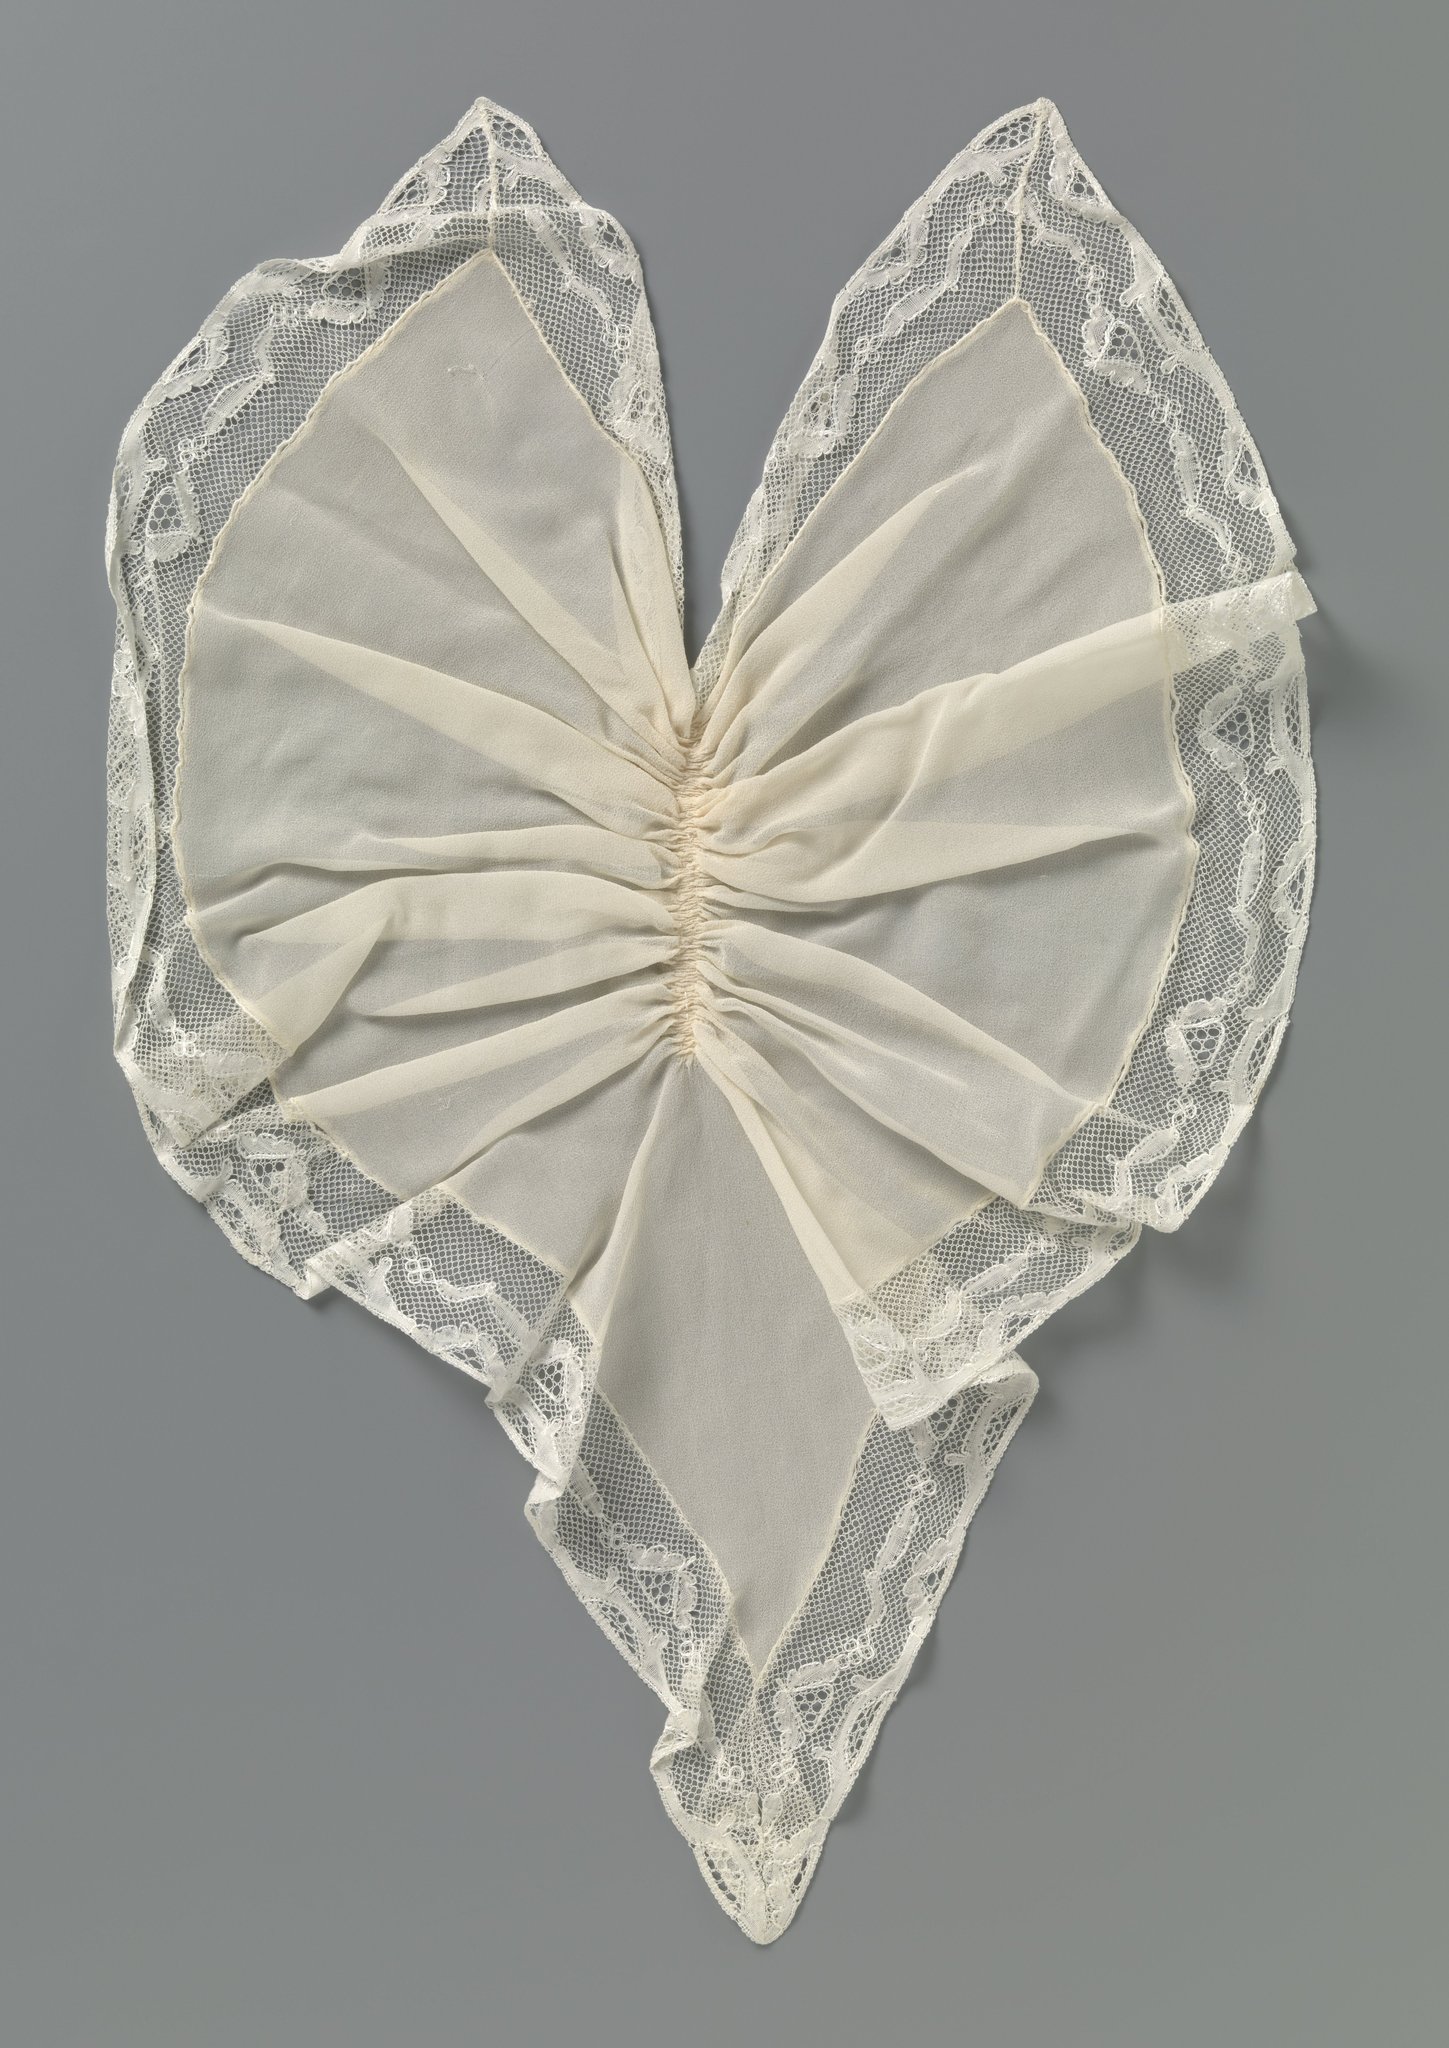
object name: jabot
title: Jabot van crèmekleurige crêpe met een rand kloskant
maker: Anonymous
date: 1900-1949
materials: cotton, textile, silk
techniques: lace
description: Jabot van crèmekleurige crêpe met langs de buitenrand een strook naturelkleurige kloskant, Valenciennes-kant. Kantpatroon met twee rijen langgerekte motiefjes op een grond met ovale mazen. De rij langs de onderkant vormt om en om een half ovaal en een driehoek, beide met een siergrond gevuld. De rij over het midden van de strook vormt driehoekjes, gevuld met een siergrond, met aan weerszijden vier kleine cirkeltjes met alleen contourdraad gemaakt. Alle motiefjes in linnenslag met dikkere en glimmende contourdraden. Contourdraden zijn a-typisch voor Valenciennes-kant. De strook is recht afgewerkt.